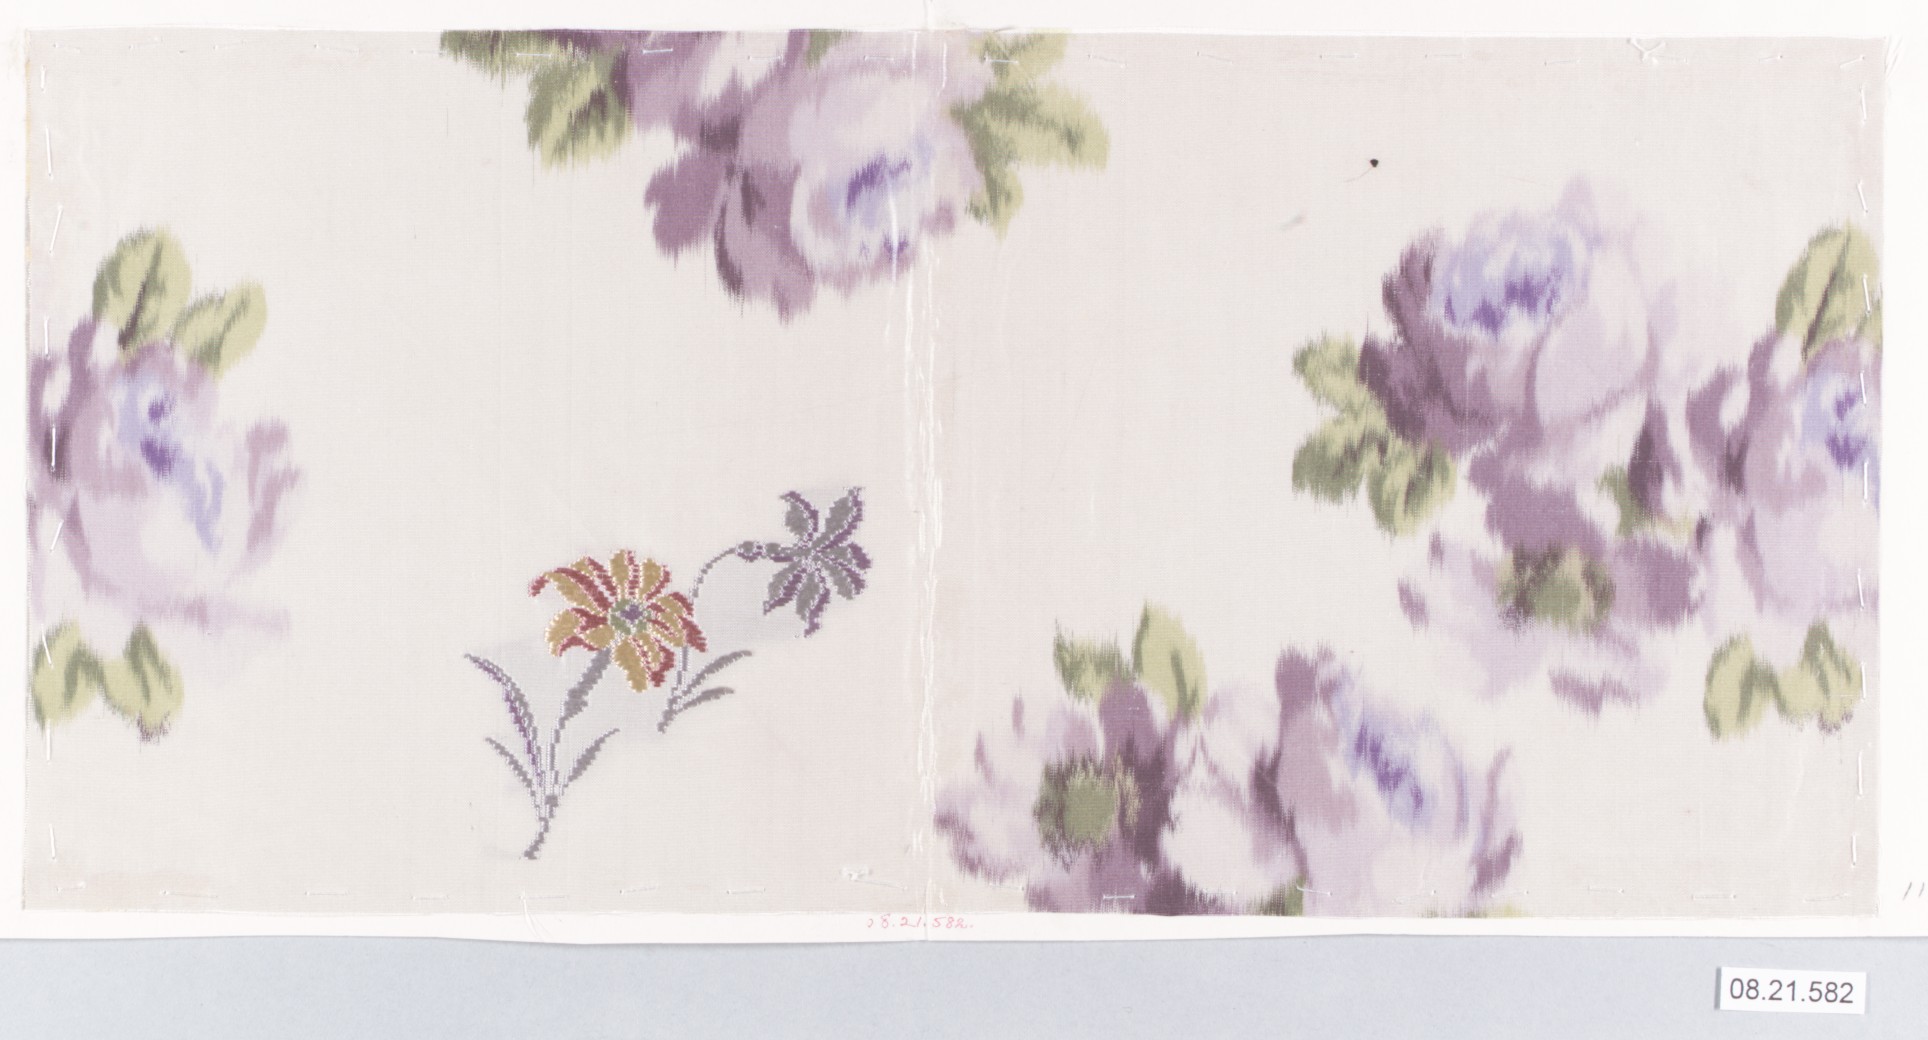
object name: textile sample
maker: Anonymous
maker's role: designer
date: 1900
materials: silk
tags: flowers